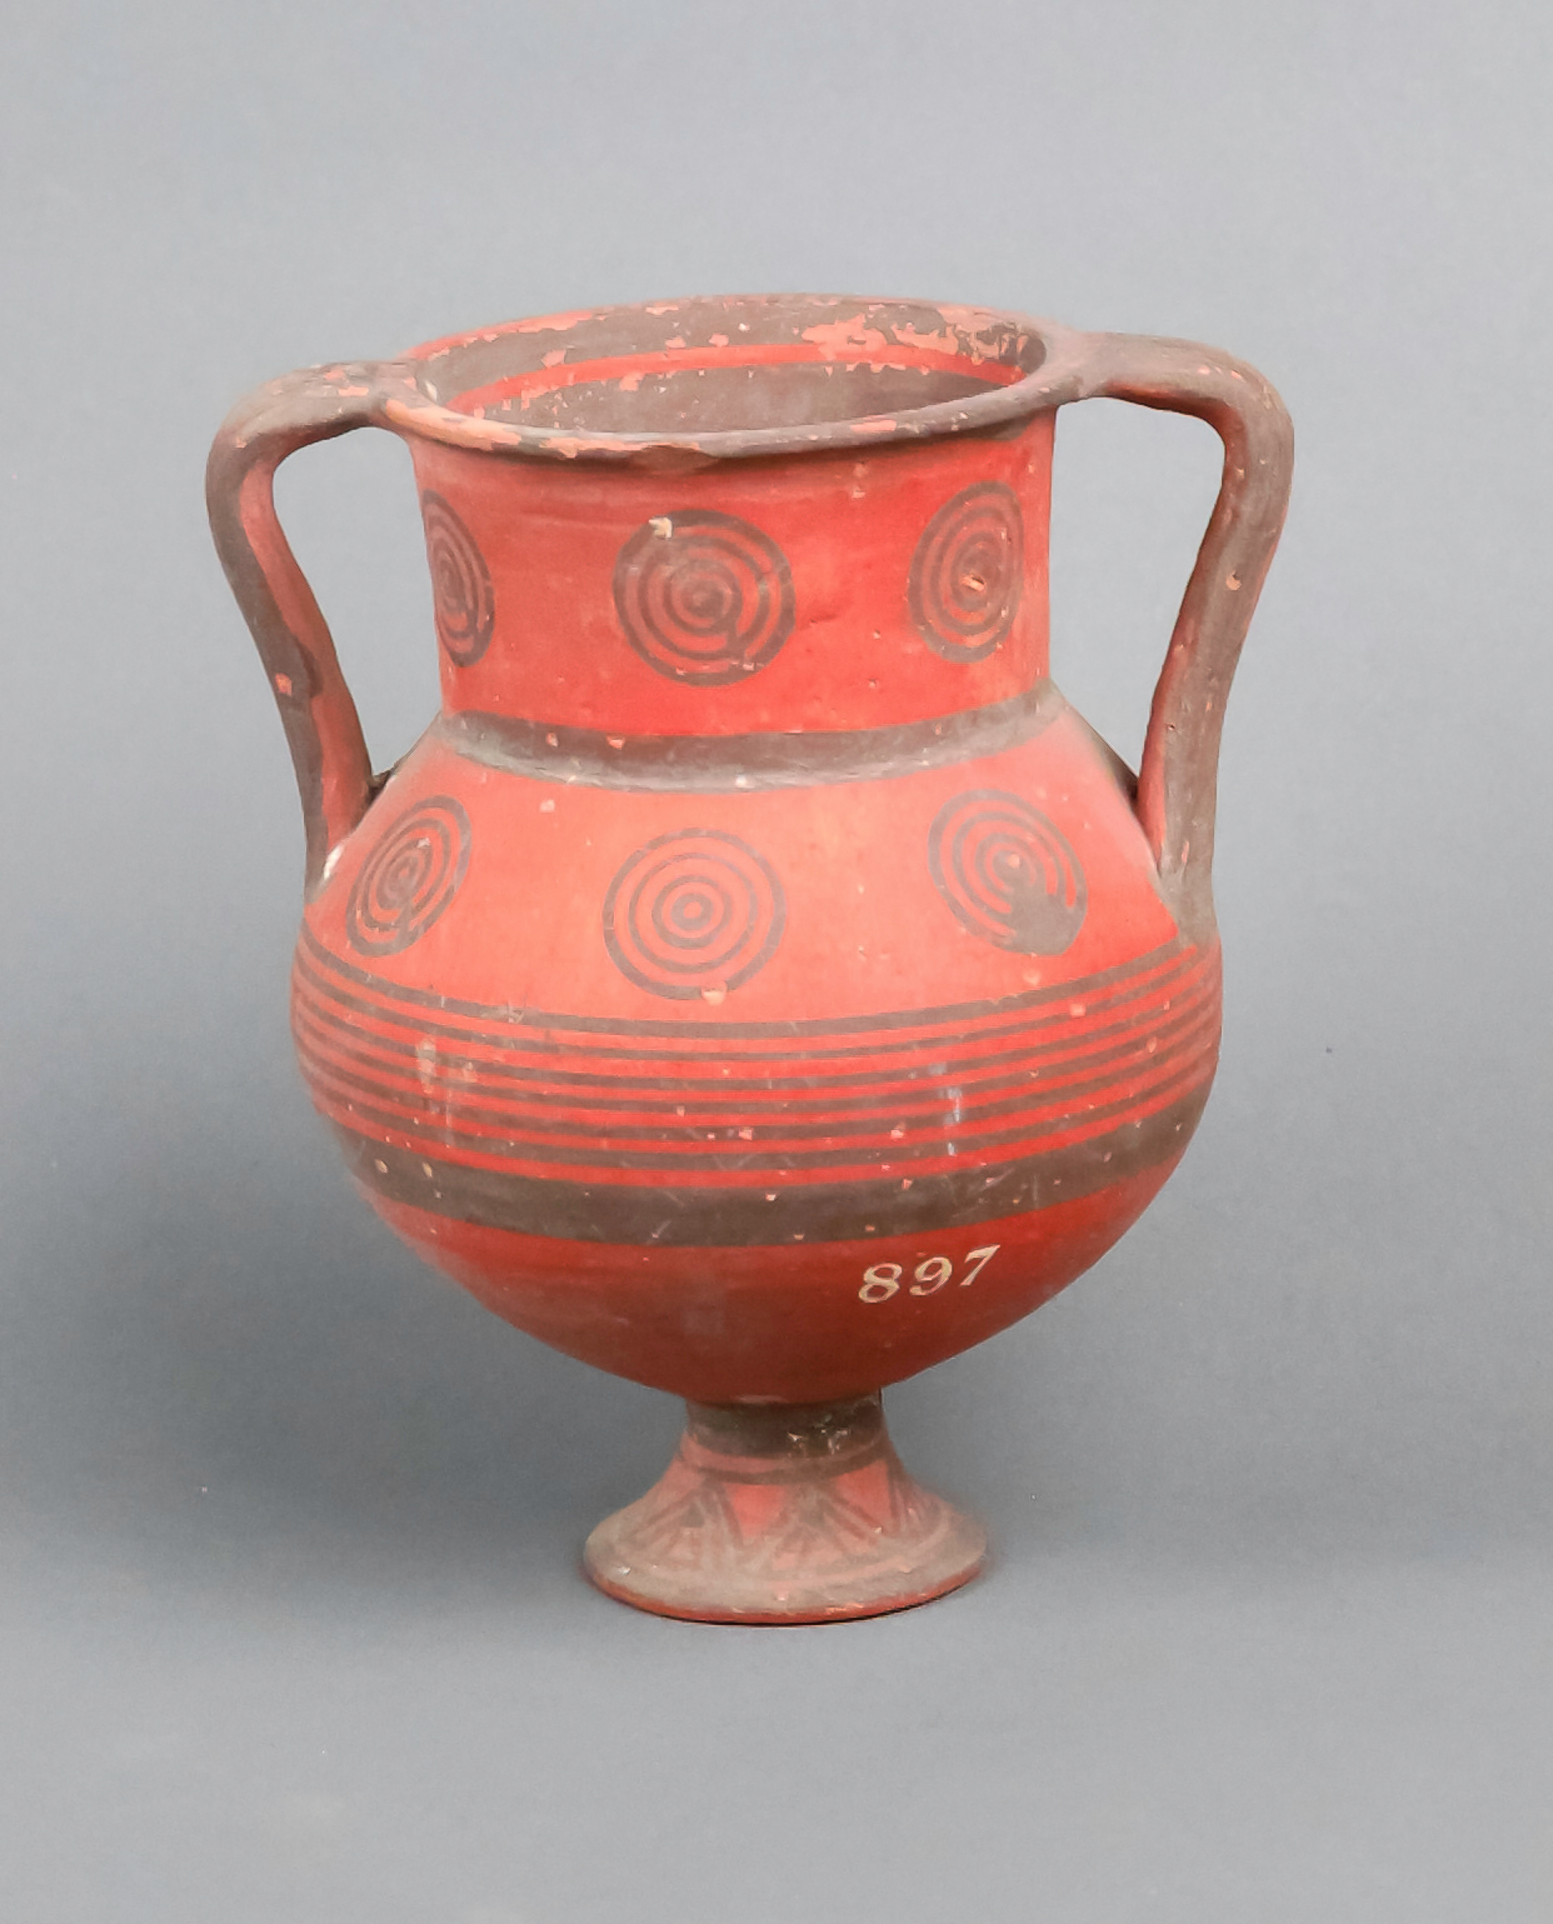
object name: amphoriskos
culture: cypriot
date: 850-750 BCE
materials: terracotta